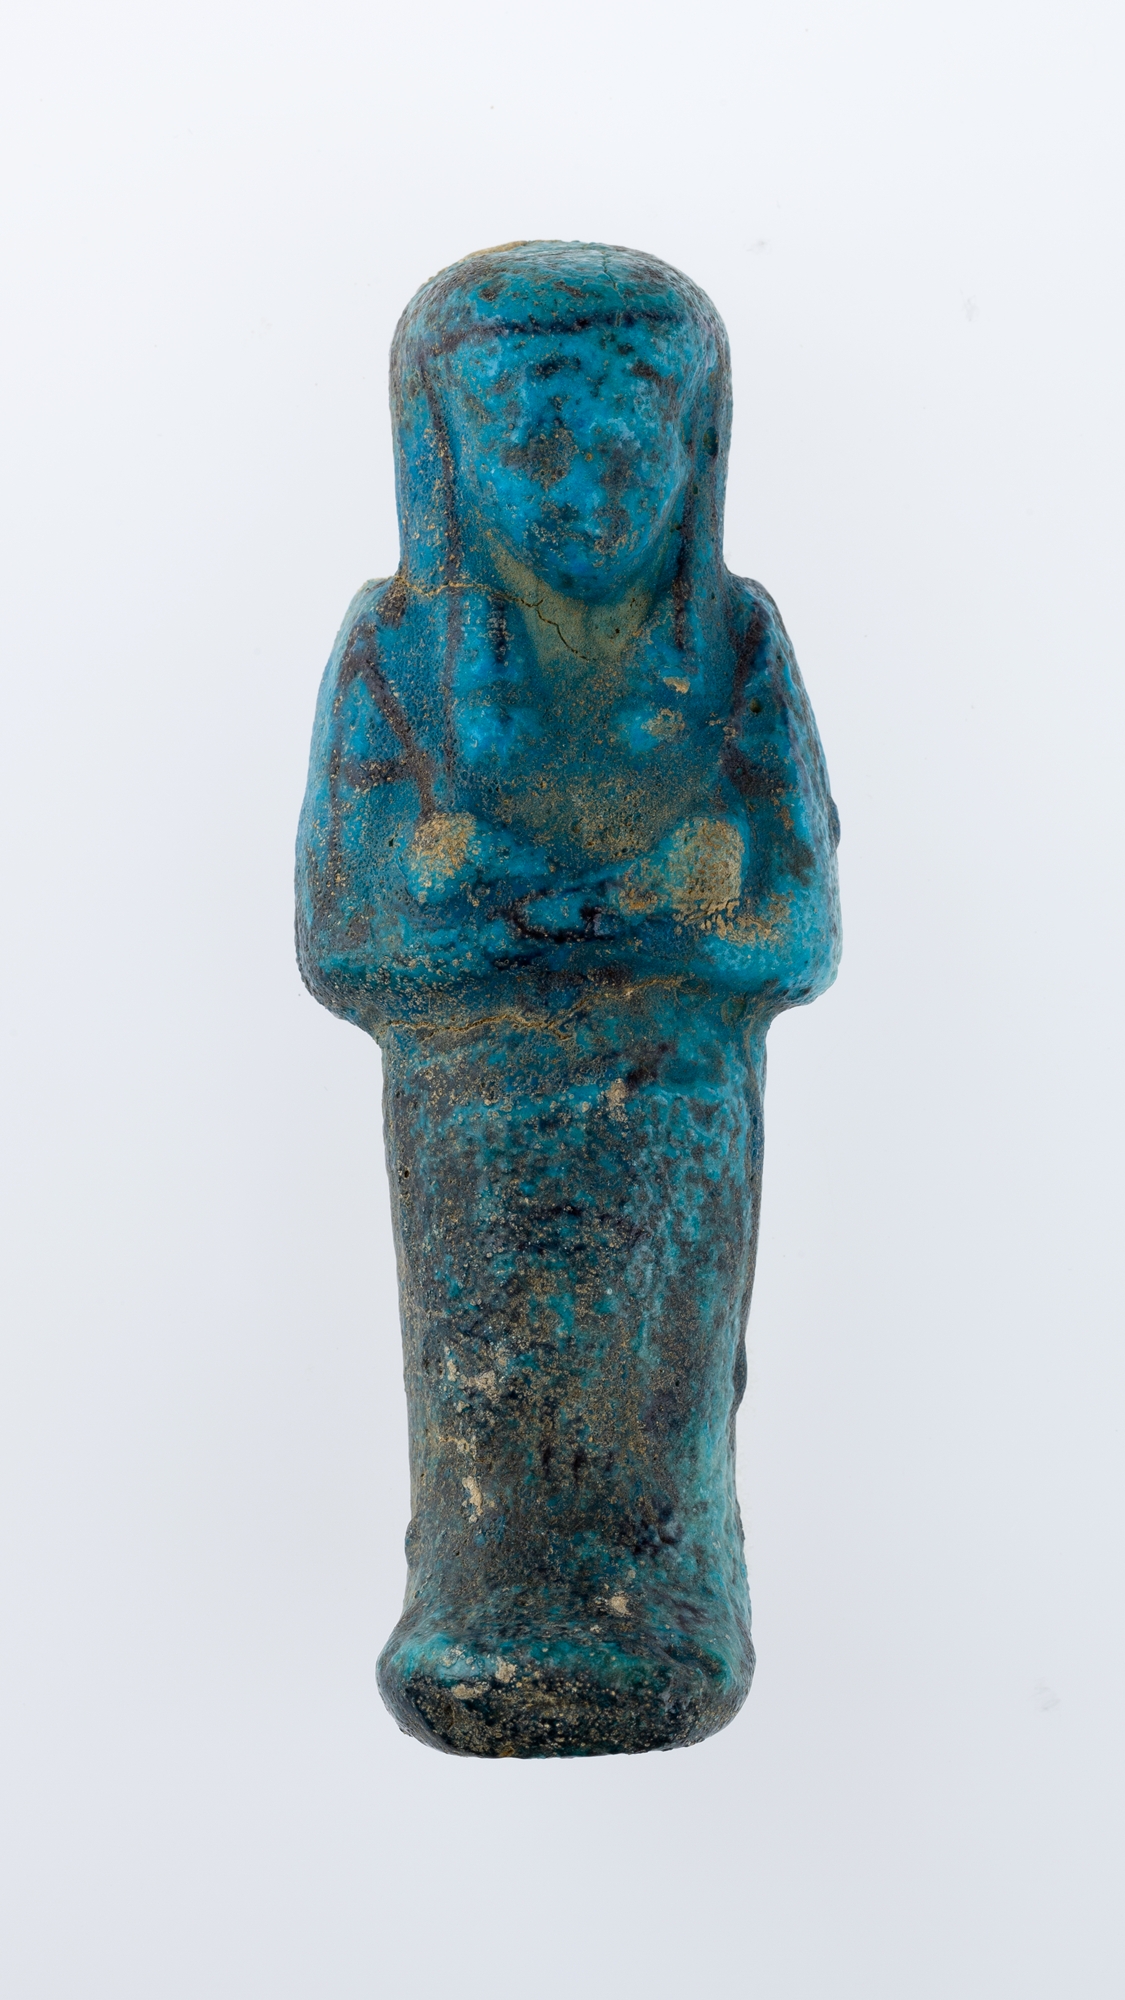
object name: shabti, henettawy c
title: Worker Shabti of Henettawy (C), Daughter of Isetemkheb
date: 990-970 BCE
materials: faience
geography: egypt